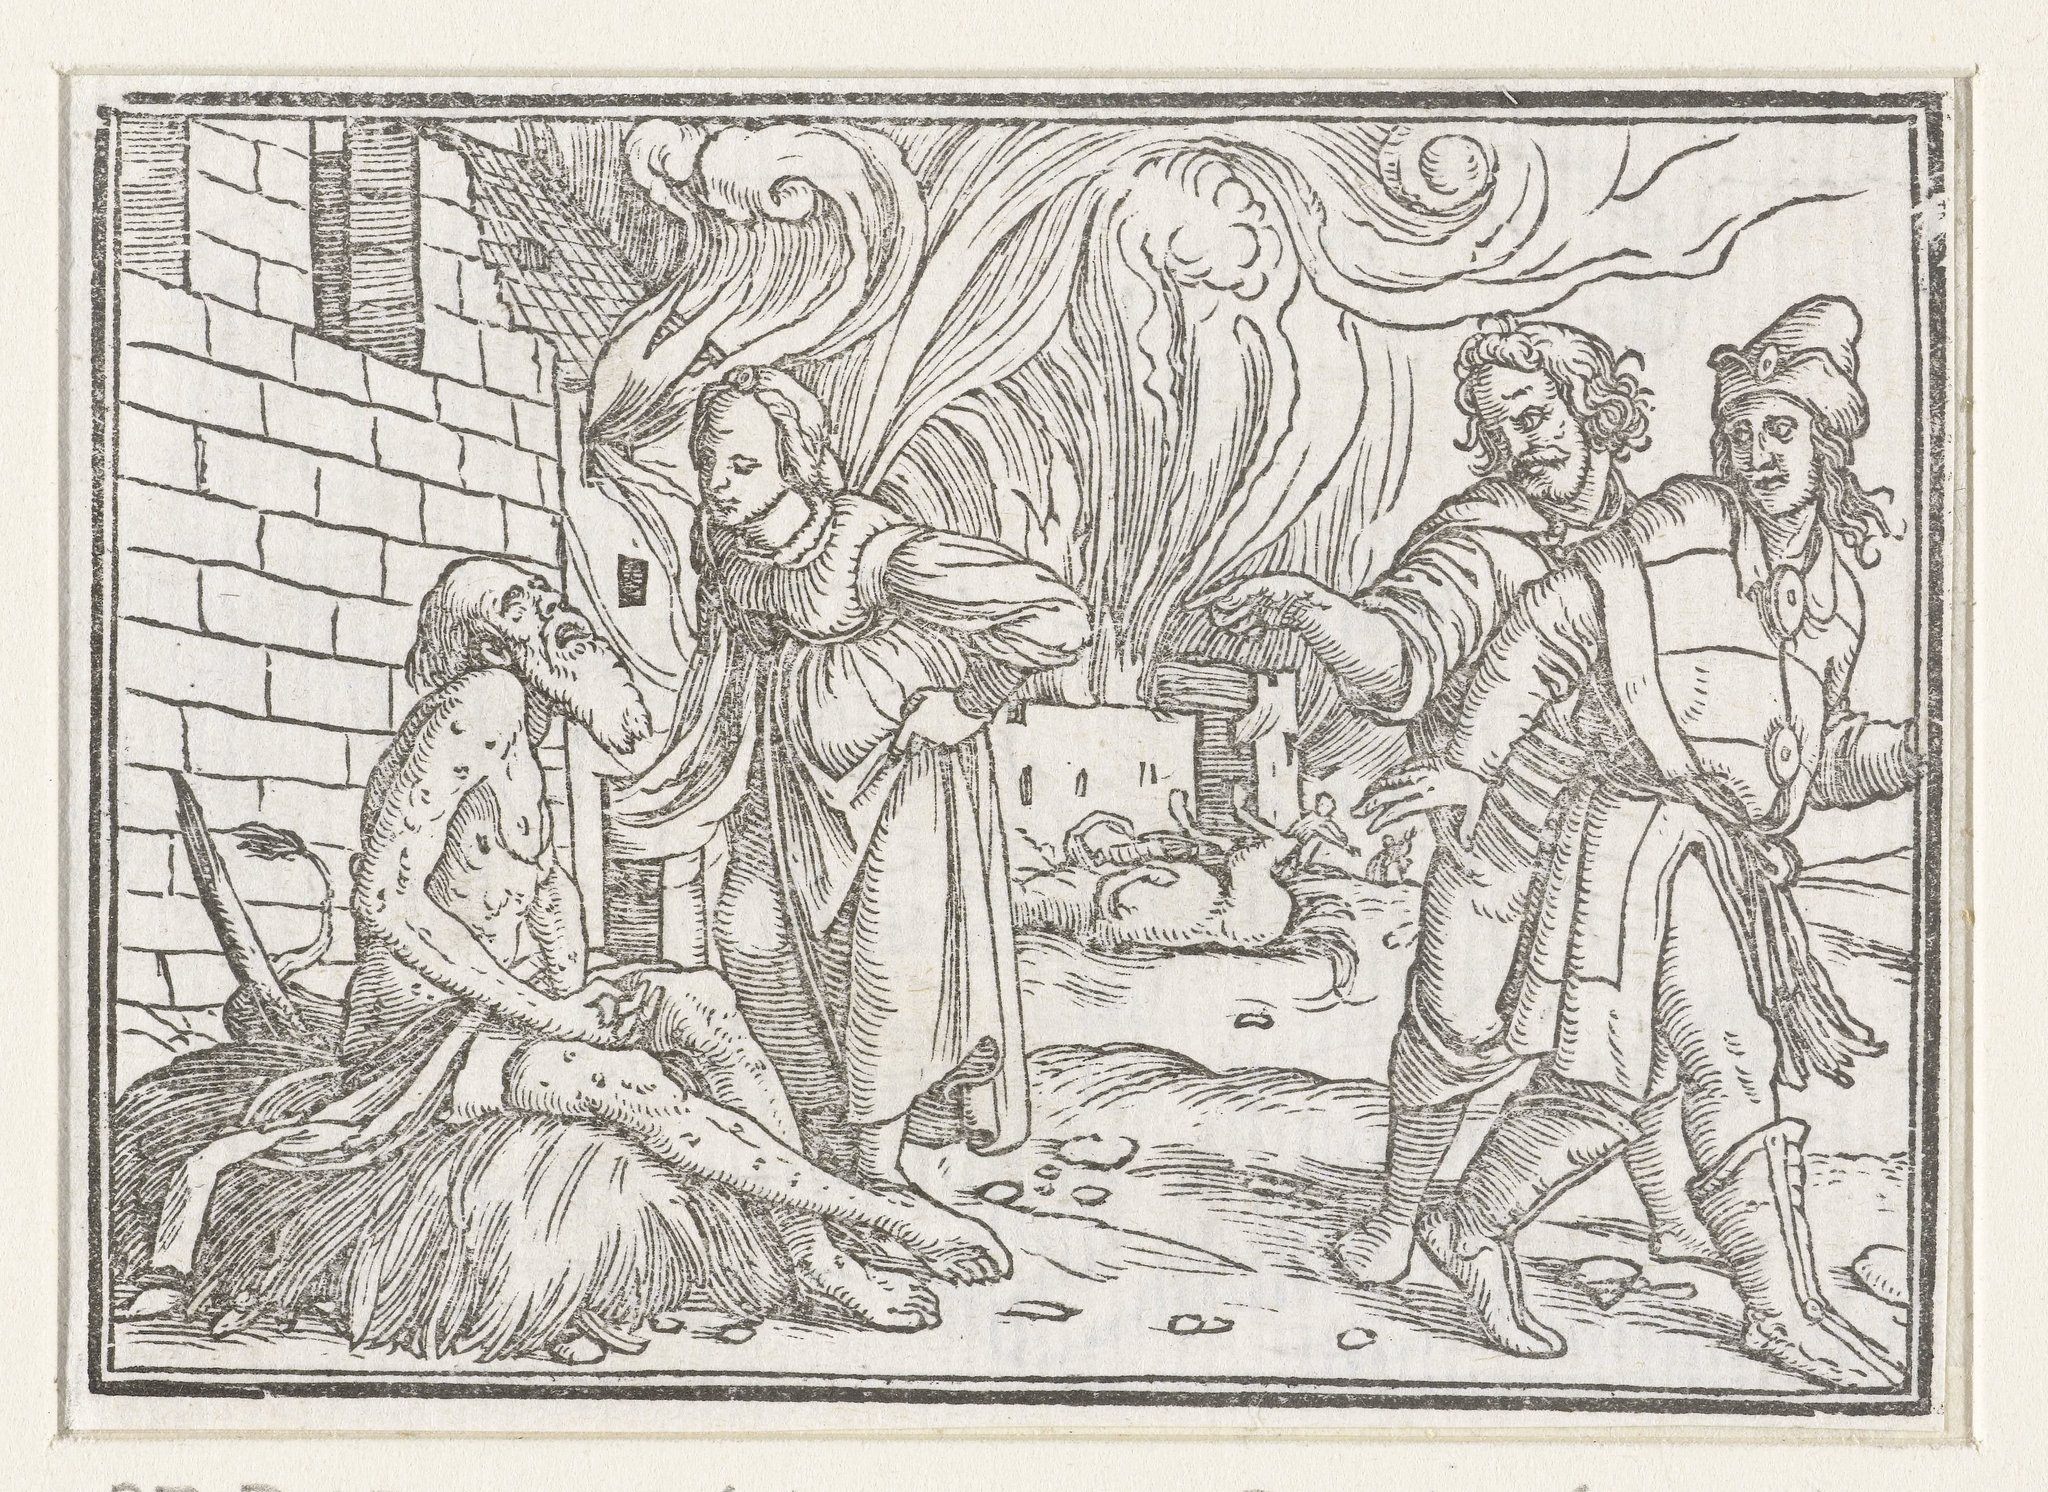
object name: book illustration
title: Job op de mesthoop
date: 1538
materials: paper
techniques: woodcut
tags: job on the dunghill visited by his friends (and wife)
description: Job zit op een mesthoop, zijn huid is overdekt met zweren. Zijn vrouw staat naast hem en lijkt hem aan te spreken, vrienden lopen voorbij en maken spottende gebaren. Op de achtergrond worden de bezittingen van Job getroffen door rampen: dieren gaan dood en gebouwen staan in brand. In de marge boven de afbeelding staat de tekst Iob I [Job 1].